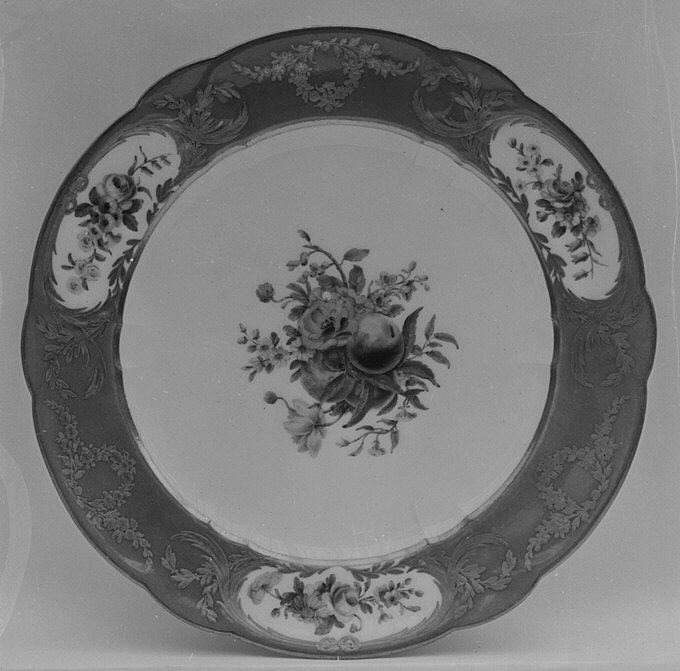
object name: plate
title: Plate (part of a service)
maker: sèvres manufactory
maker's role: manufactory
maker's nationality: french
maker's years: 1740-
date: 1777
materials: soft paste porcelain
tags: flowers